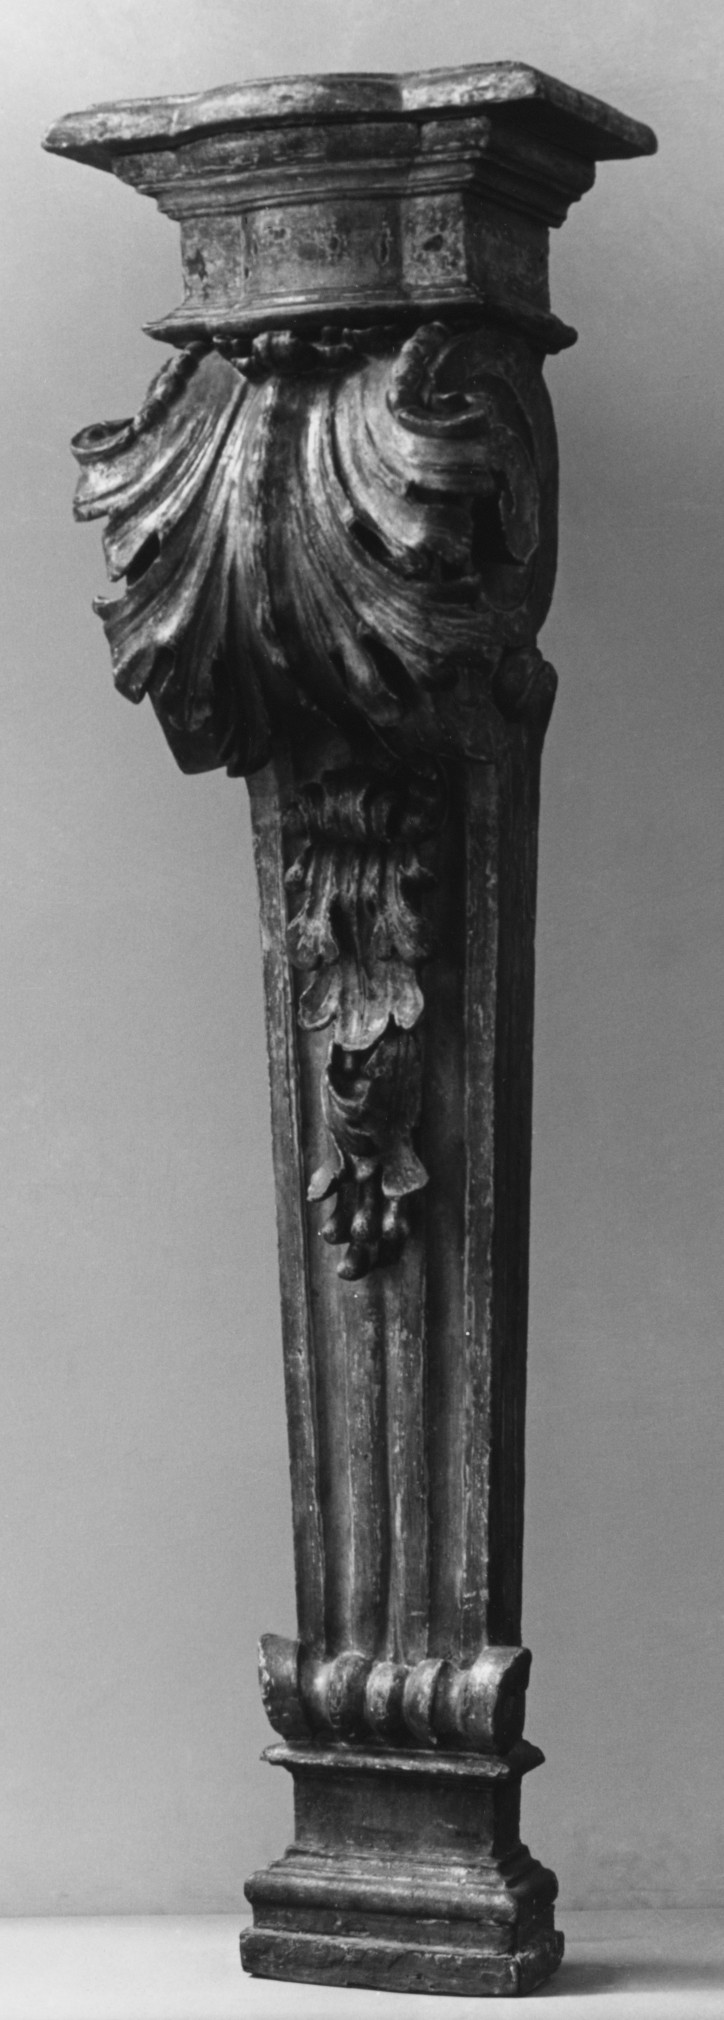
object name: pedestal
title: Wall pedestal (one of a pair)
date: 1651-1700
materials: wood